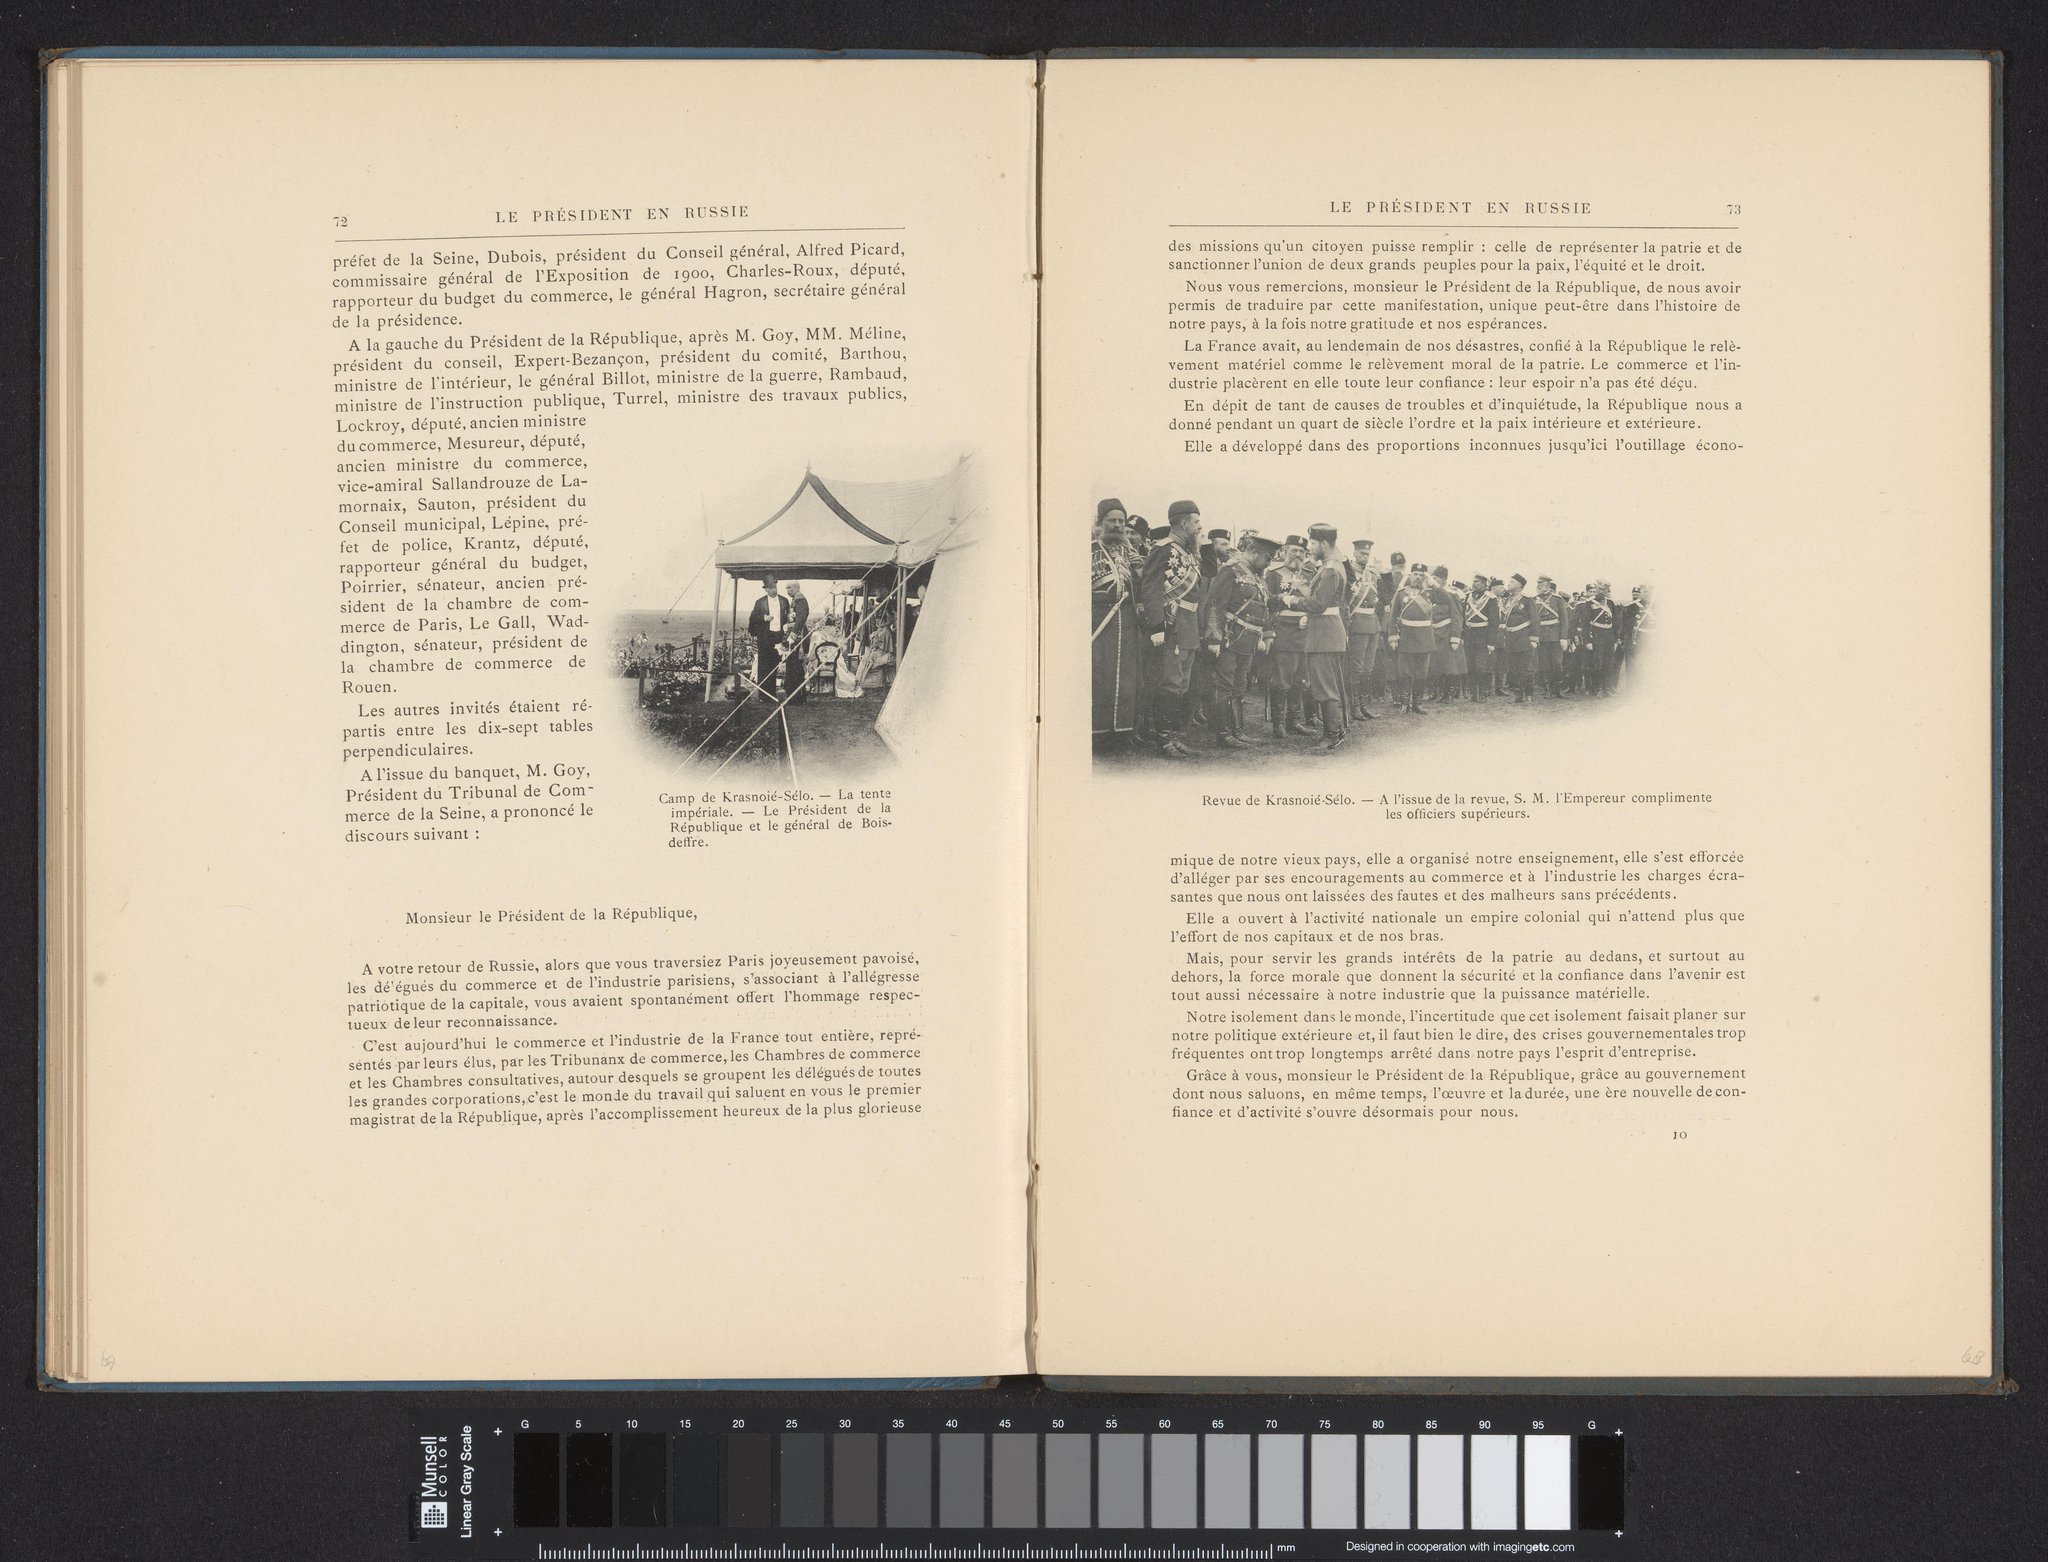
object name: page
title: President Félix Faure en generaal Raoul Le Mouton de Boisdeffre bekijken een defilé te Krasnoye Selo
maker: Anonymous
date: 1897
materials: paper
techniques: photograph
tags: paris, commander-in-chief, general, marshal, military parade, pageant, ruler, sovereign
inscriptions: inscription: ‘Revue de Krasnoié-Sélo-(...) de Boisdeffre.’